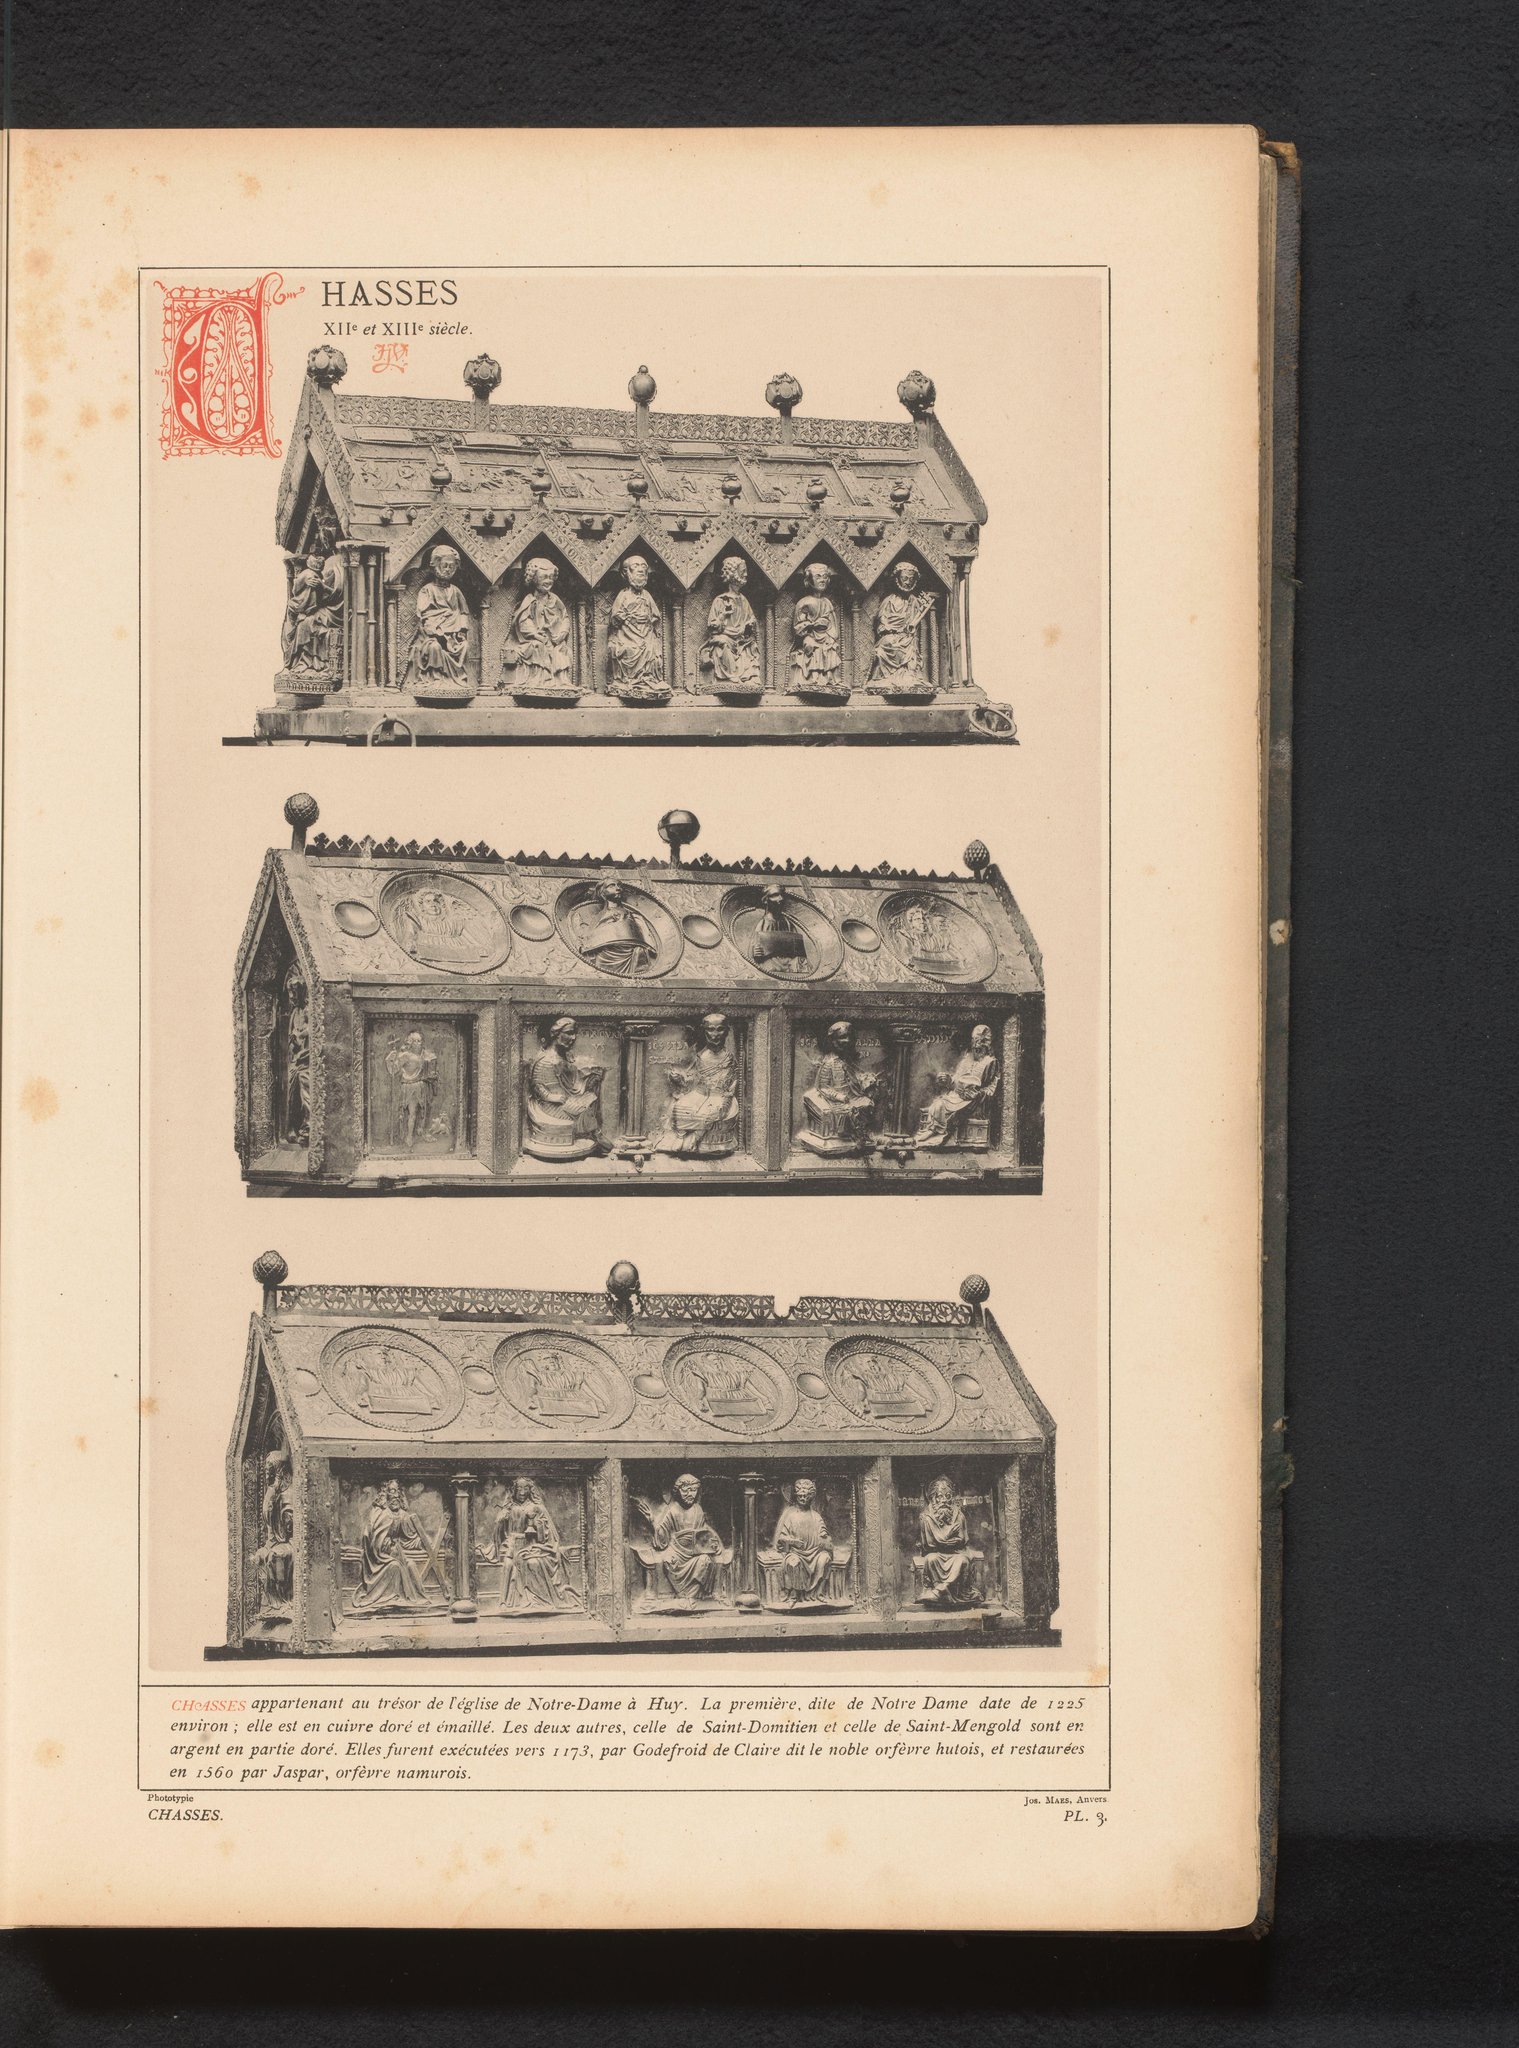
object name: photomechanical print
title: Drie relikwieënkasten uit de Collegiale kerk Onze-Lieve-Vrouw en Domitianus van Hoei, België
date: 1882-1887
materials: paper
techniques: photograph, photolithography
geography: antwerp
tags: relics (and reliquaries)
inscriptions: monogram: ‘JJvY’, inscription: ‘CHASSES appartenant au (...)’, inscription: ‘CHASSES. - PL. 3.’